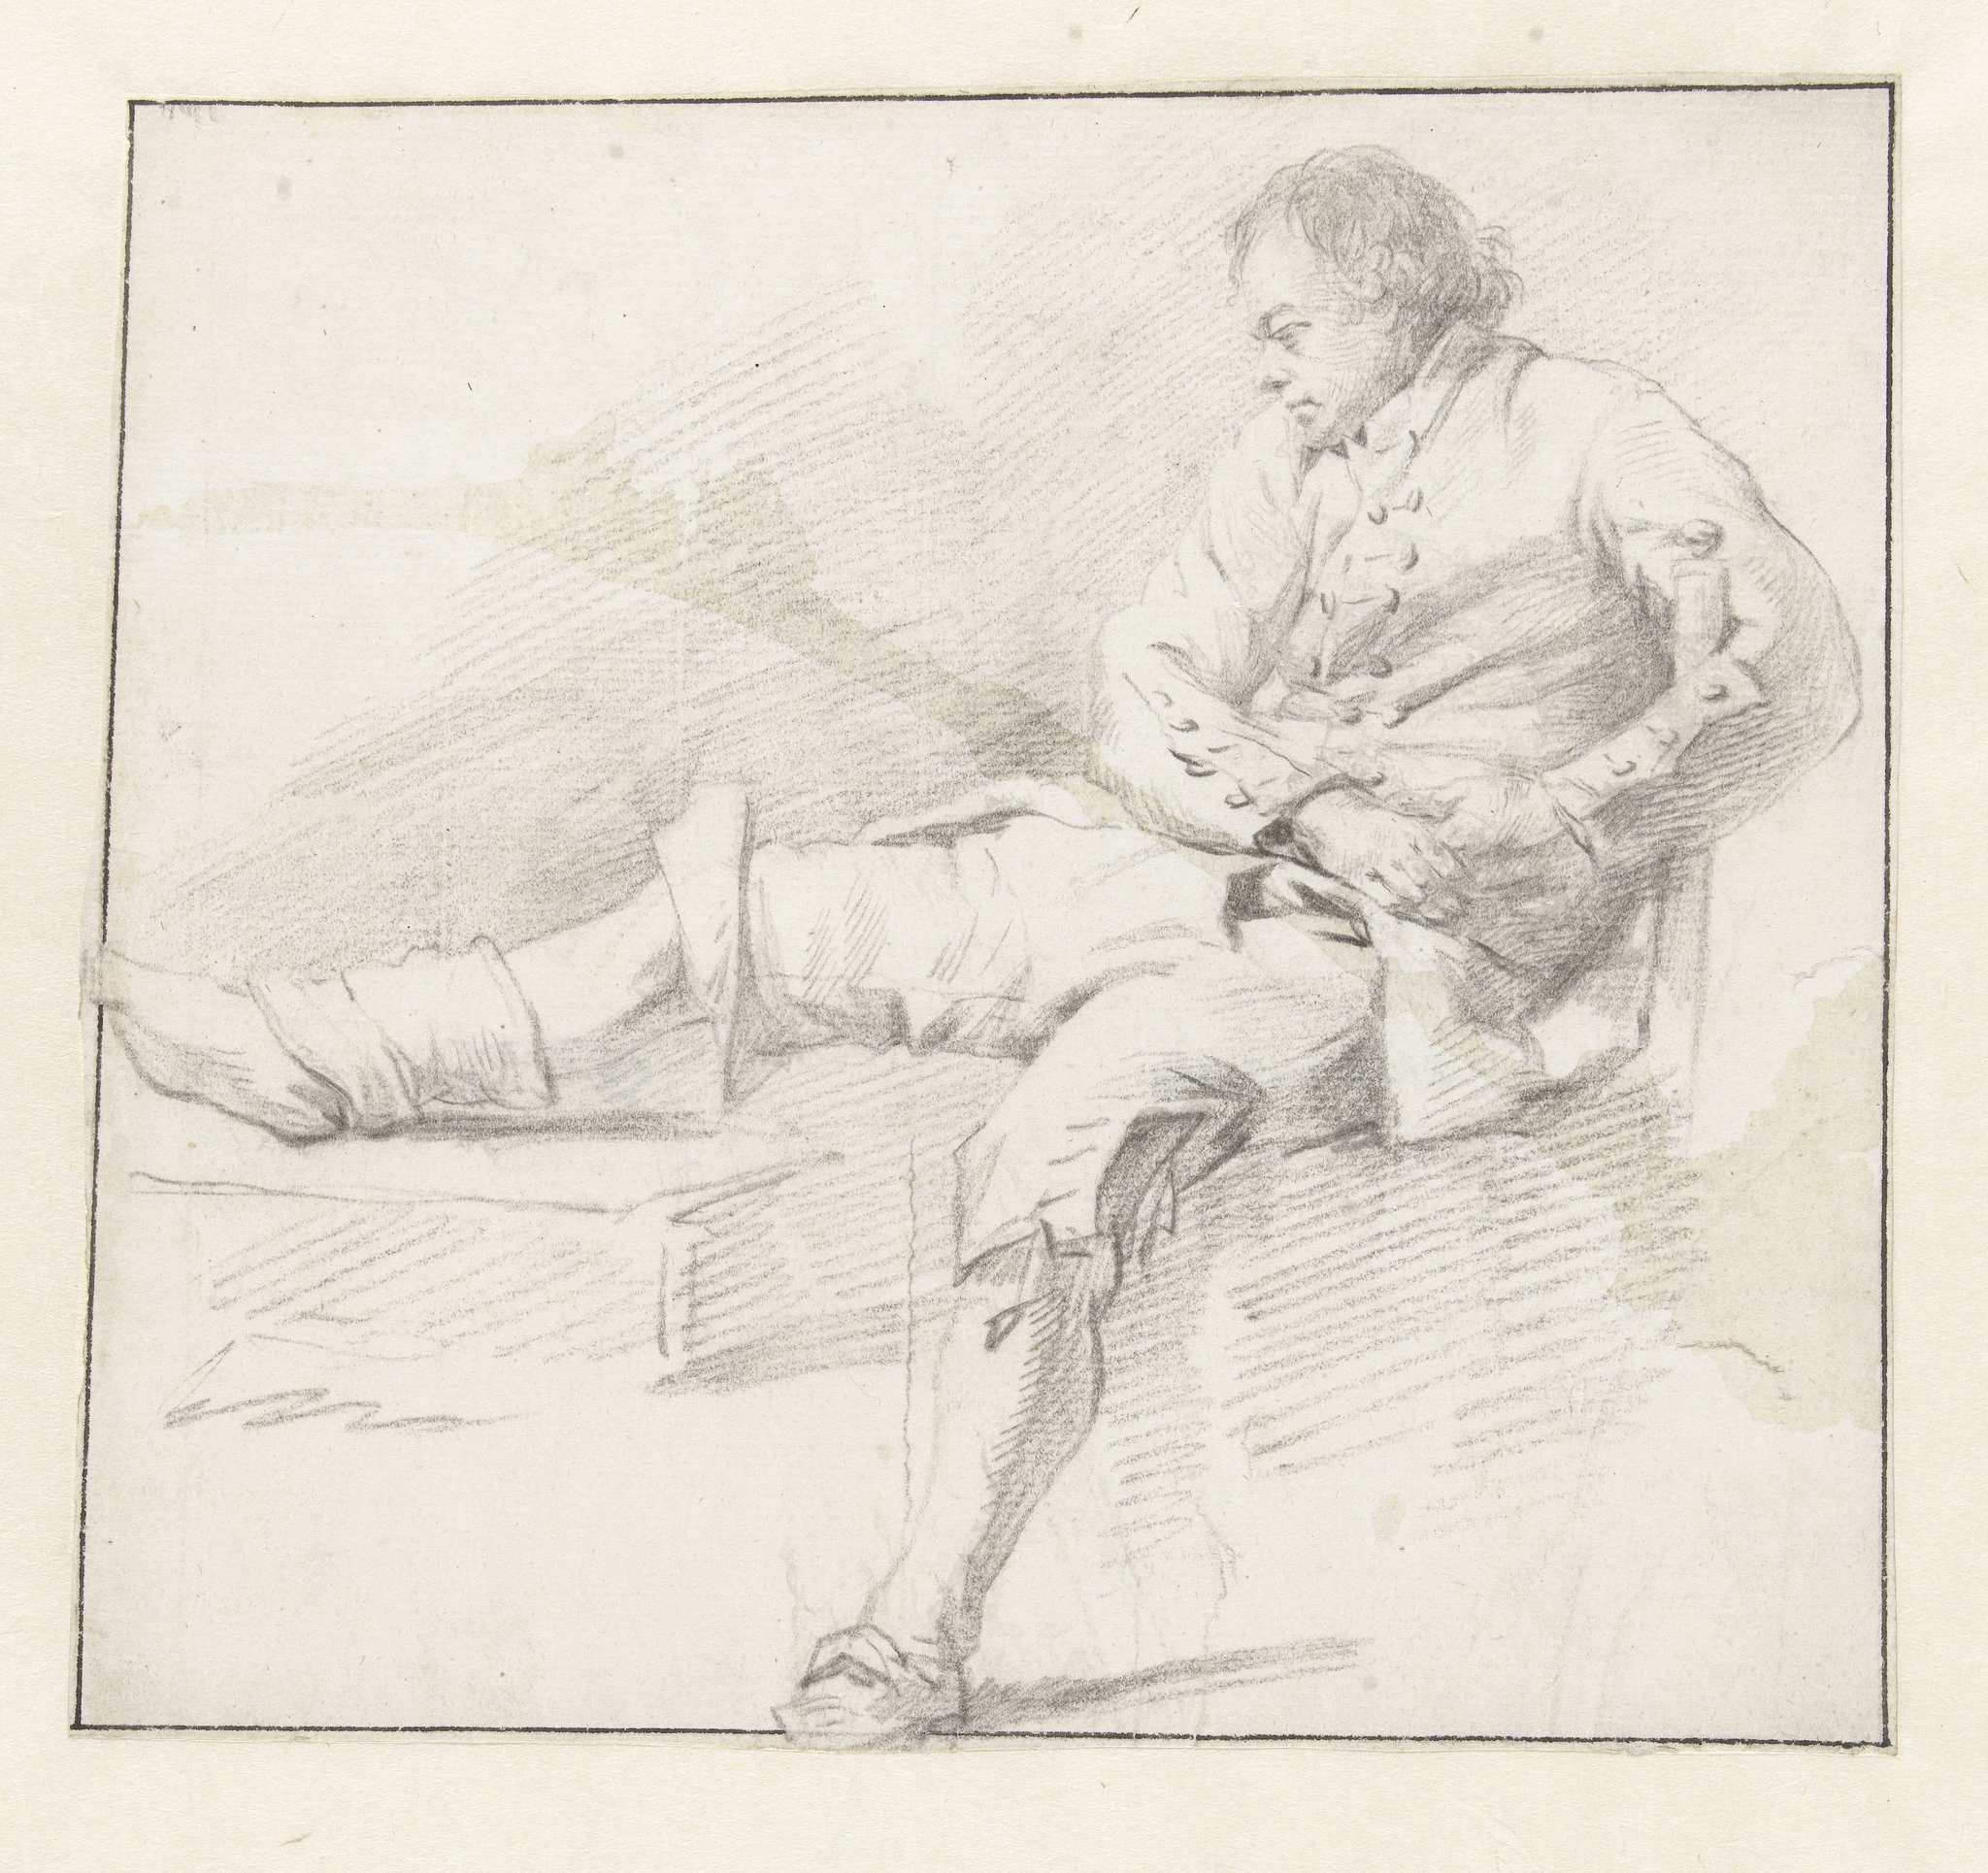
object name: drawing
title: Figuurstudie van een zittende man, naar links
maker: hermanus van brussel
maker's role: draughtsman, print maker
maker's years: 1763-1815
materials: chalk, graphite, ink, paper, pencil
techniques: pen